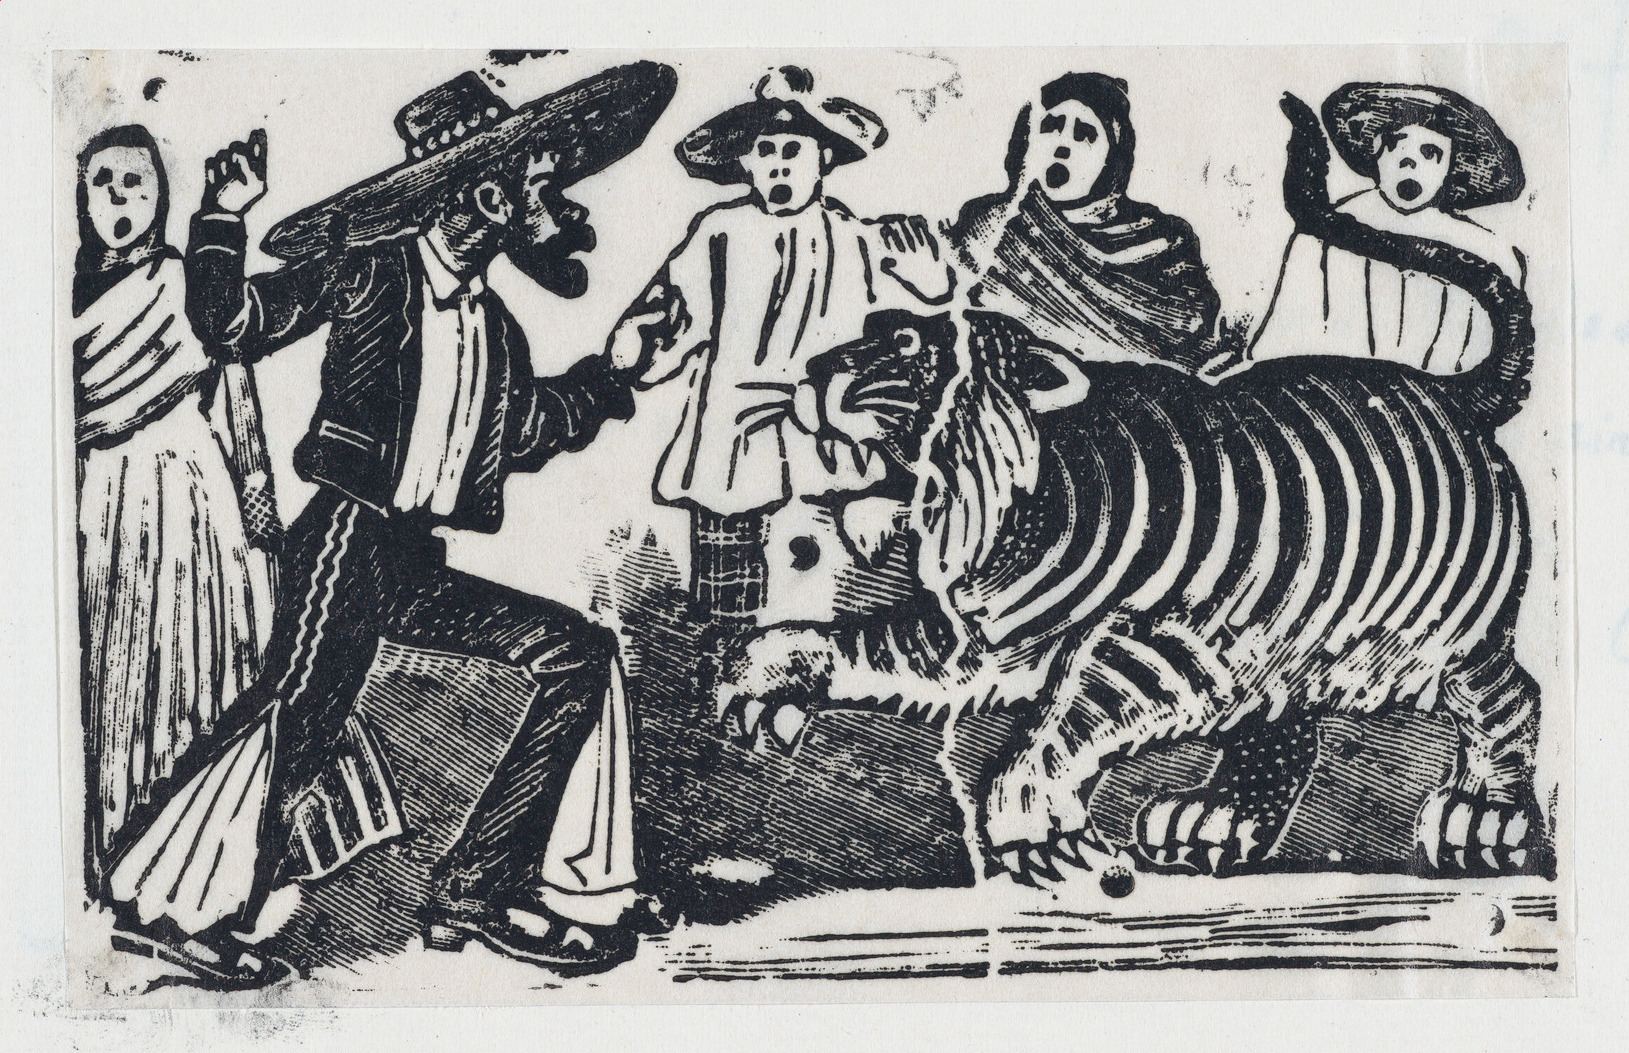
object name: print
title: The brave man from Gaudalajara facing a tiger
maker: josé guadalupe posada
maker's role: artist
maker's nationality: mexican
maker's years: 1852-1913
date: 1900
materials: metal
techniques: engraving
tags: men,women,tigers